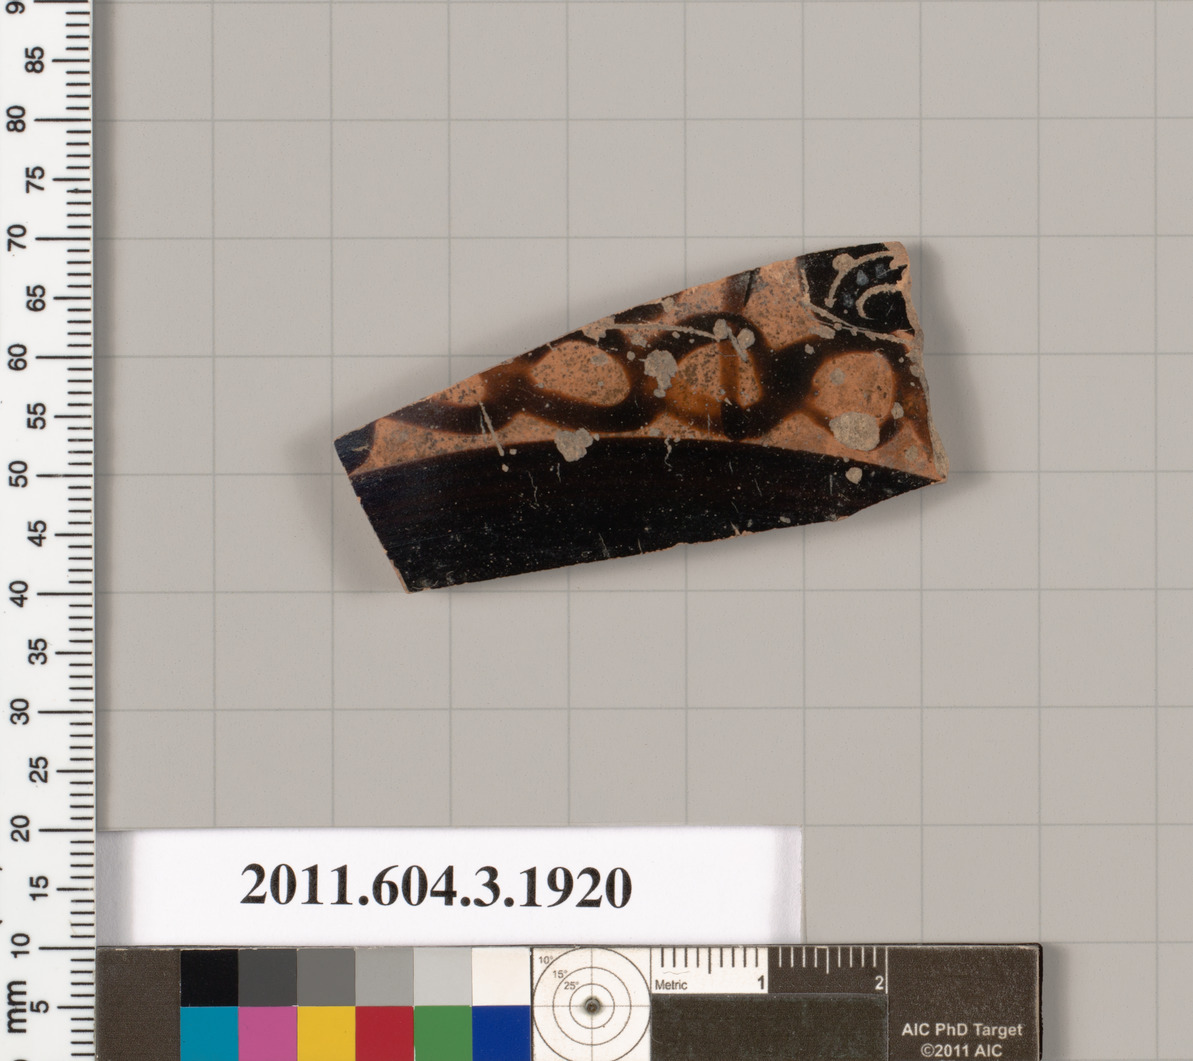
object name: kylix or skyphos fragment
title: Terracotta fragment of a kylix (drinking cup) or a skyphos (deep drinking cup)?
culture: greek, attic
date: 534-468 BCE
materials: terracotta